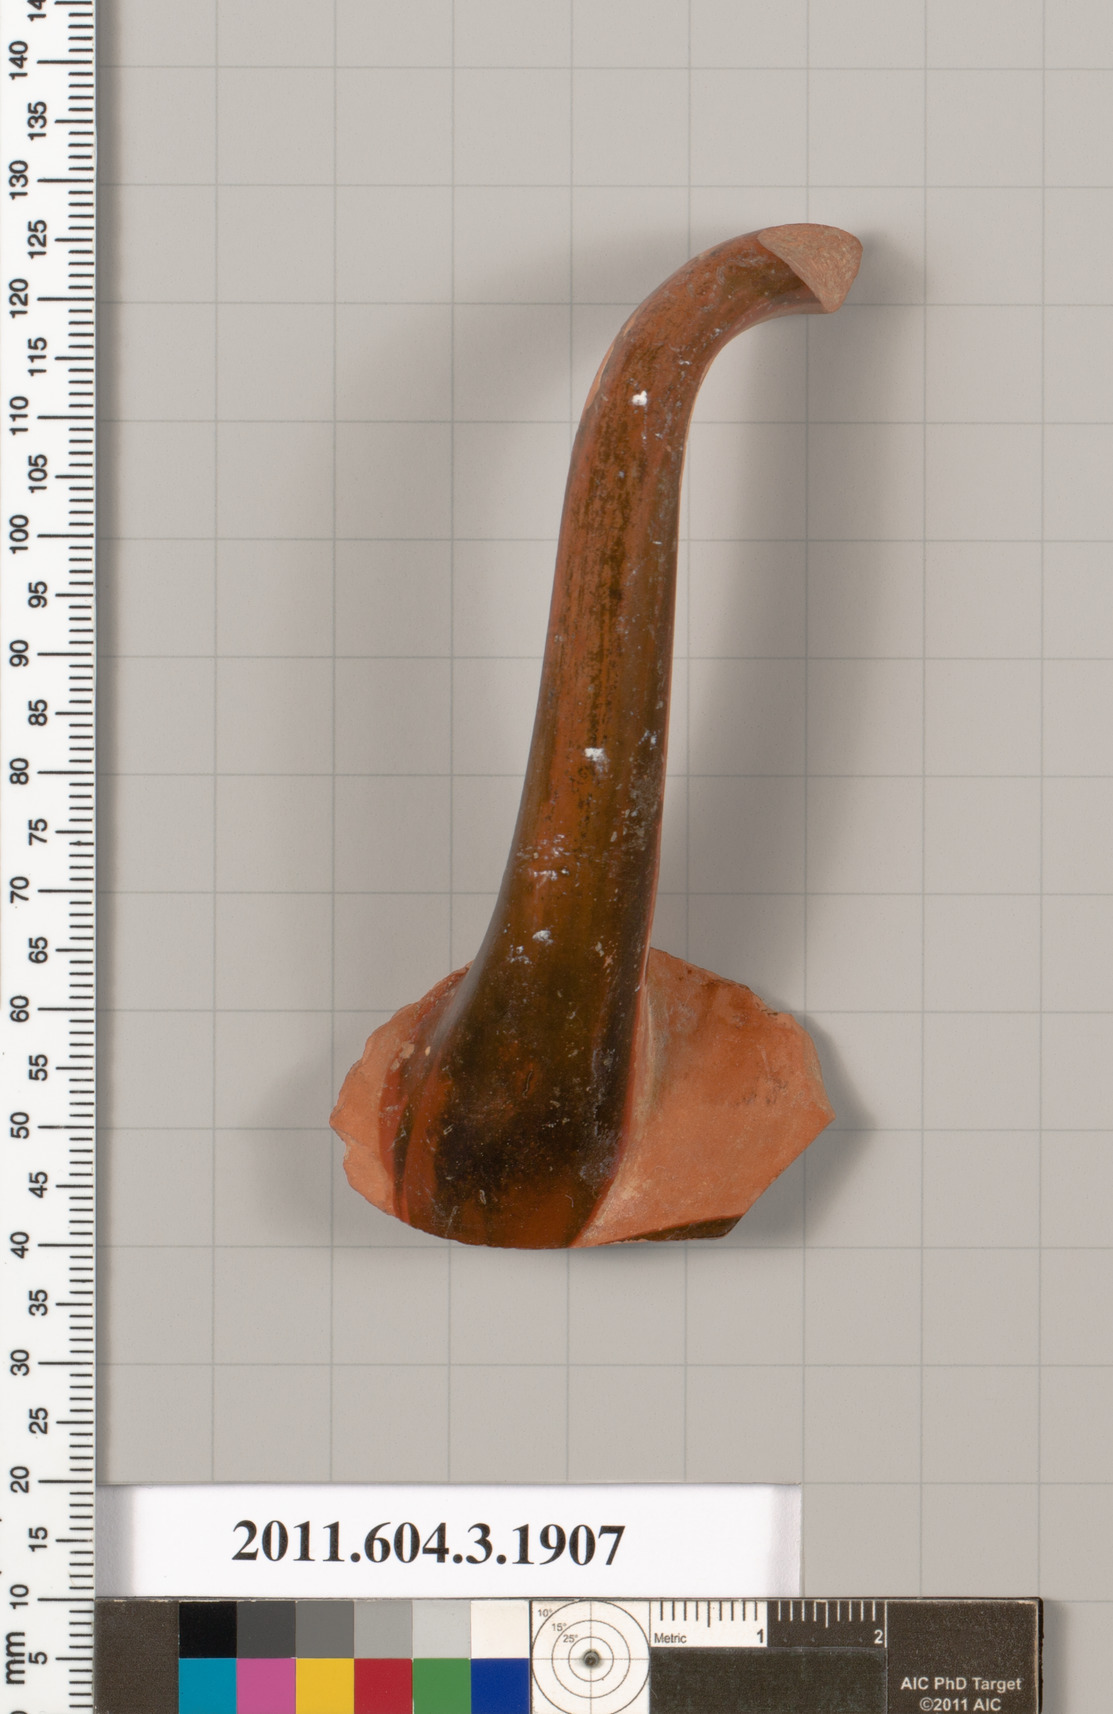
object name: kylix fragment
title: Terracotta fragment of a kylix (drinking cup)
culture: greek, attic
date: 600-401 BCE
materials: terracotta